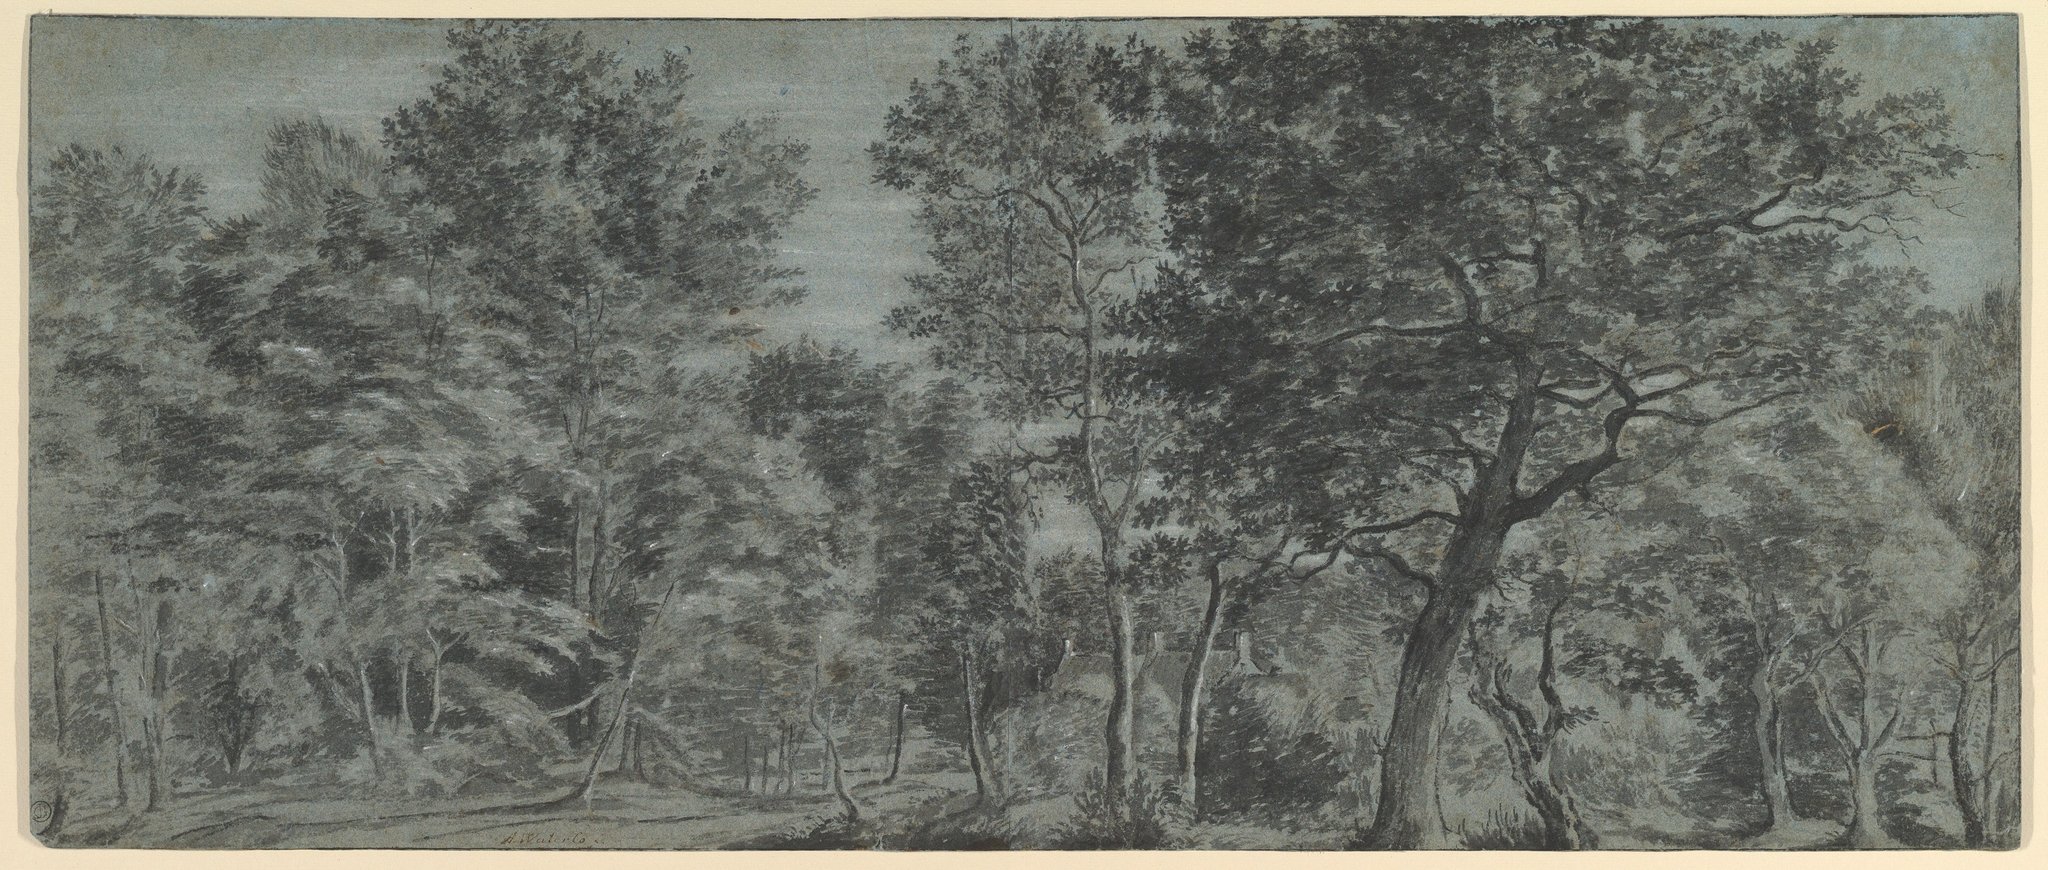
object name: drawing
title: View of a Forest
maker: joris abrahamsz. van der haagen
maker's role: artist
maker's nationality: dutch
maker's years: 1613-1669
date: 1601-1700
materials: gouache, ink, paper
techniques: heightening, pen, wash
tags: forests